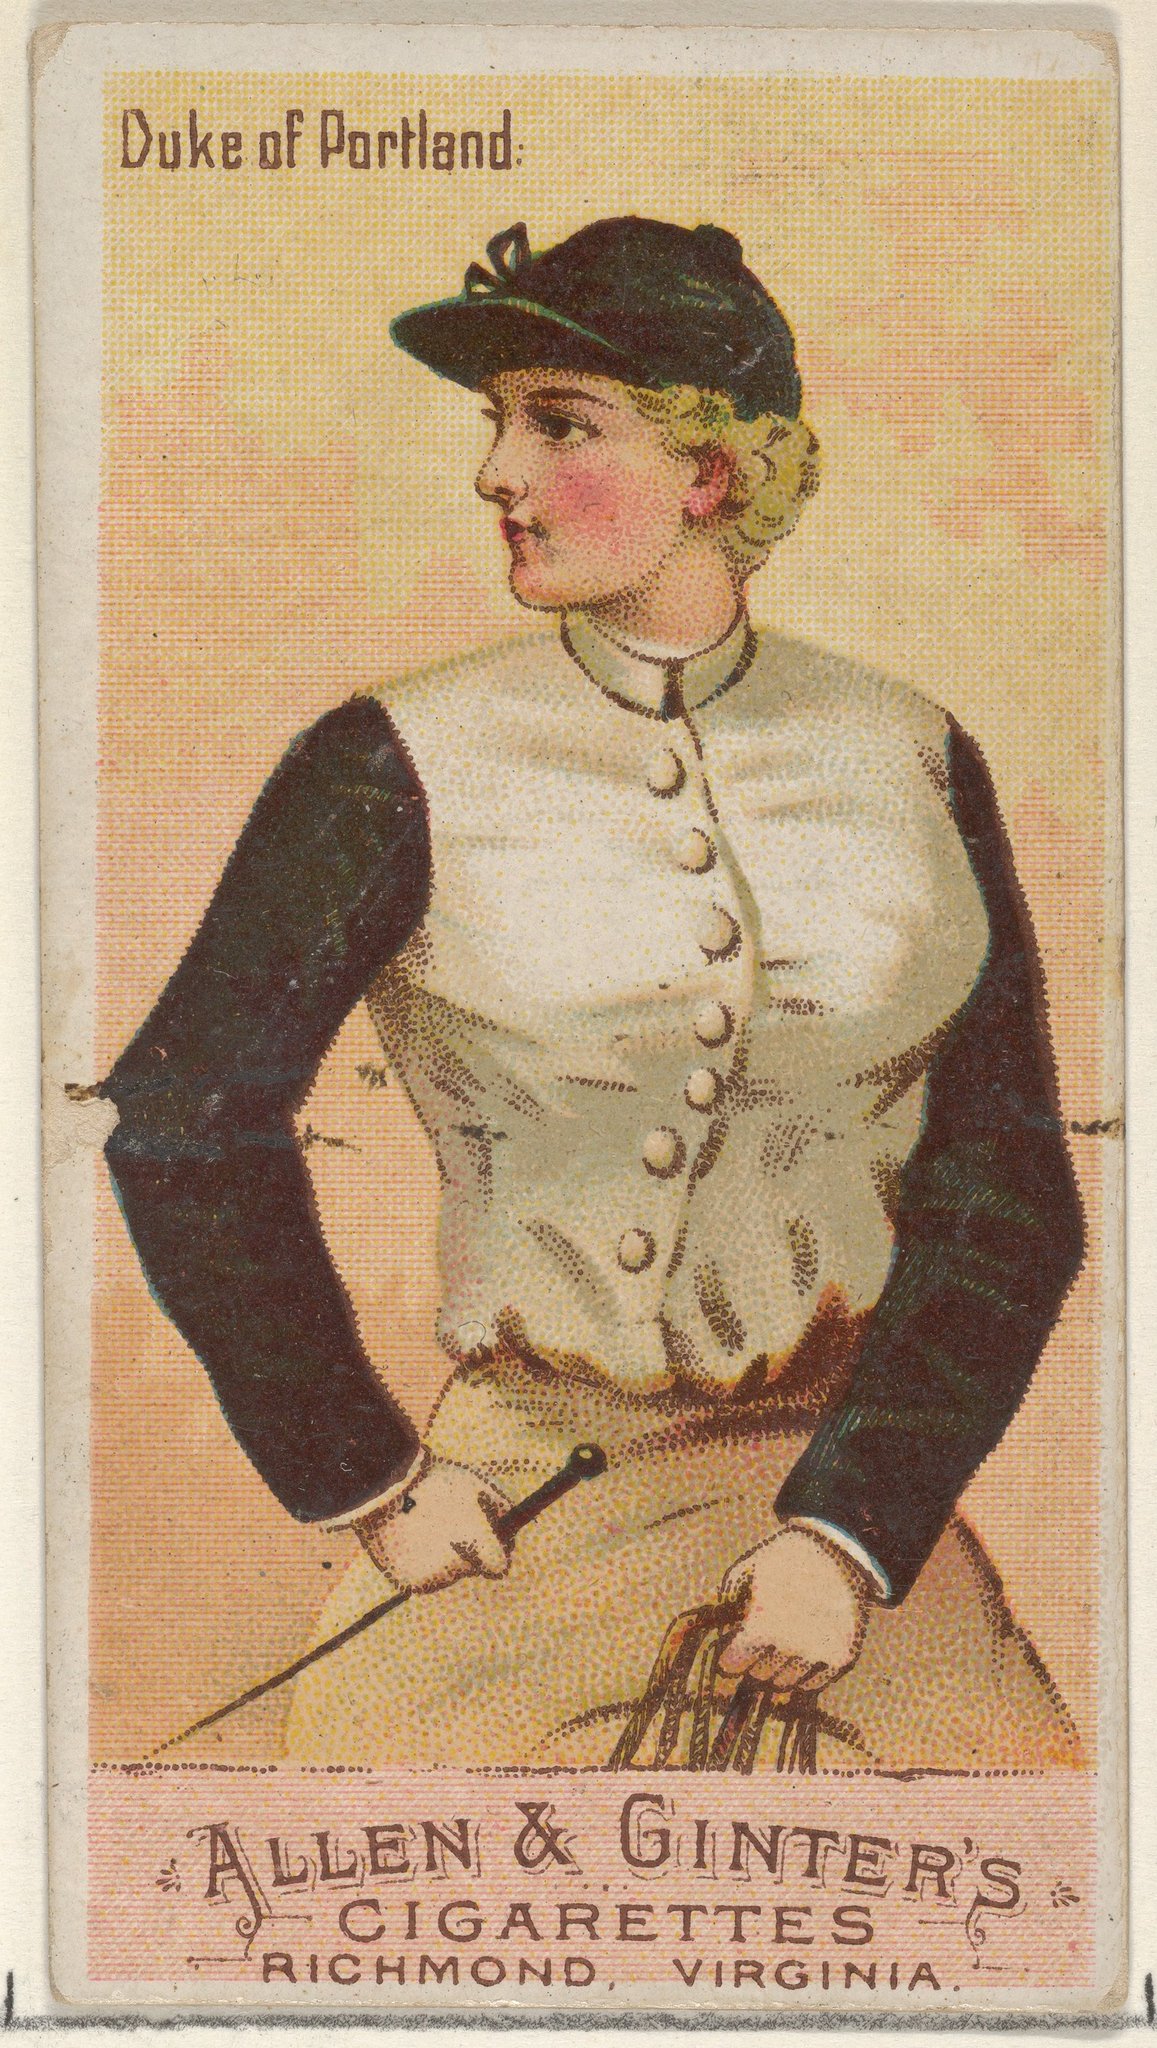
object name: print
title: Duke of Portland, from the Racing Colors of the World series (N22a) for Allen & Ginter Cigarettes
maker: allen & ginter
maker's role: publisher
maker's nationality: american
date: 1888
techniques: color lithograph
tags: profiles,women,athletes,jockeys